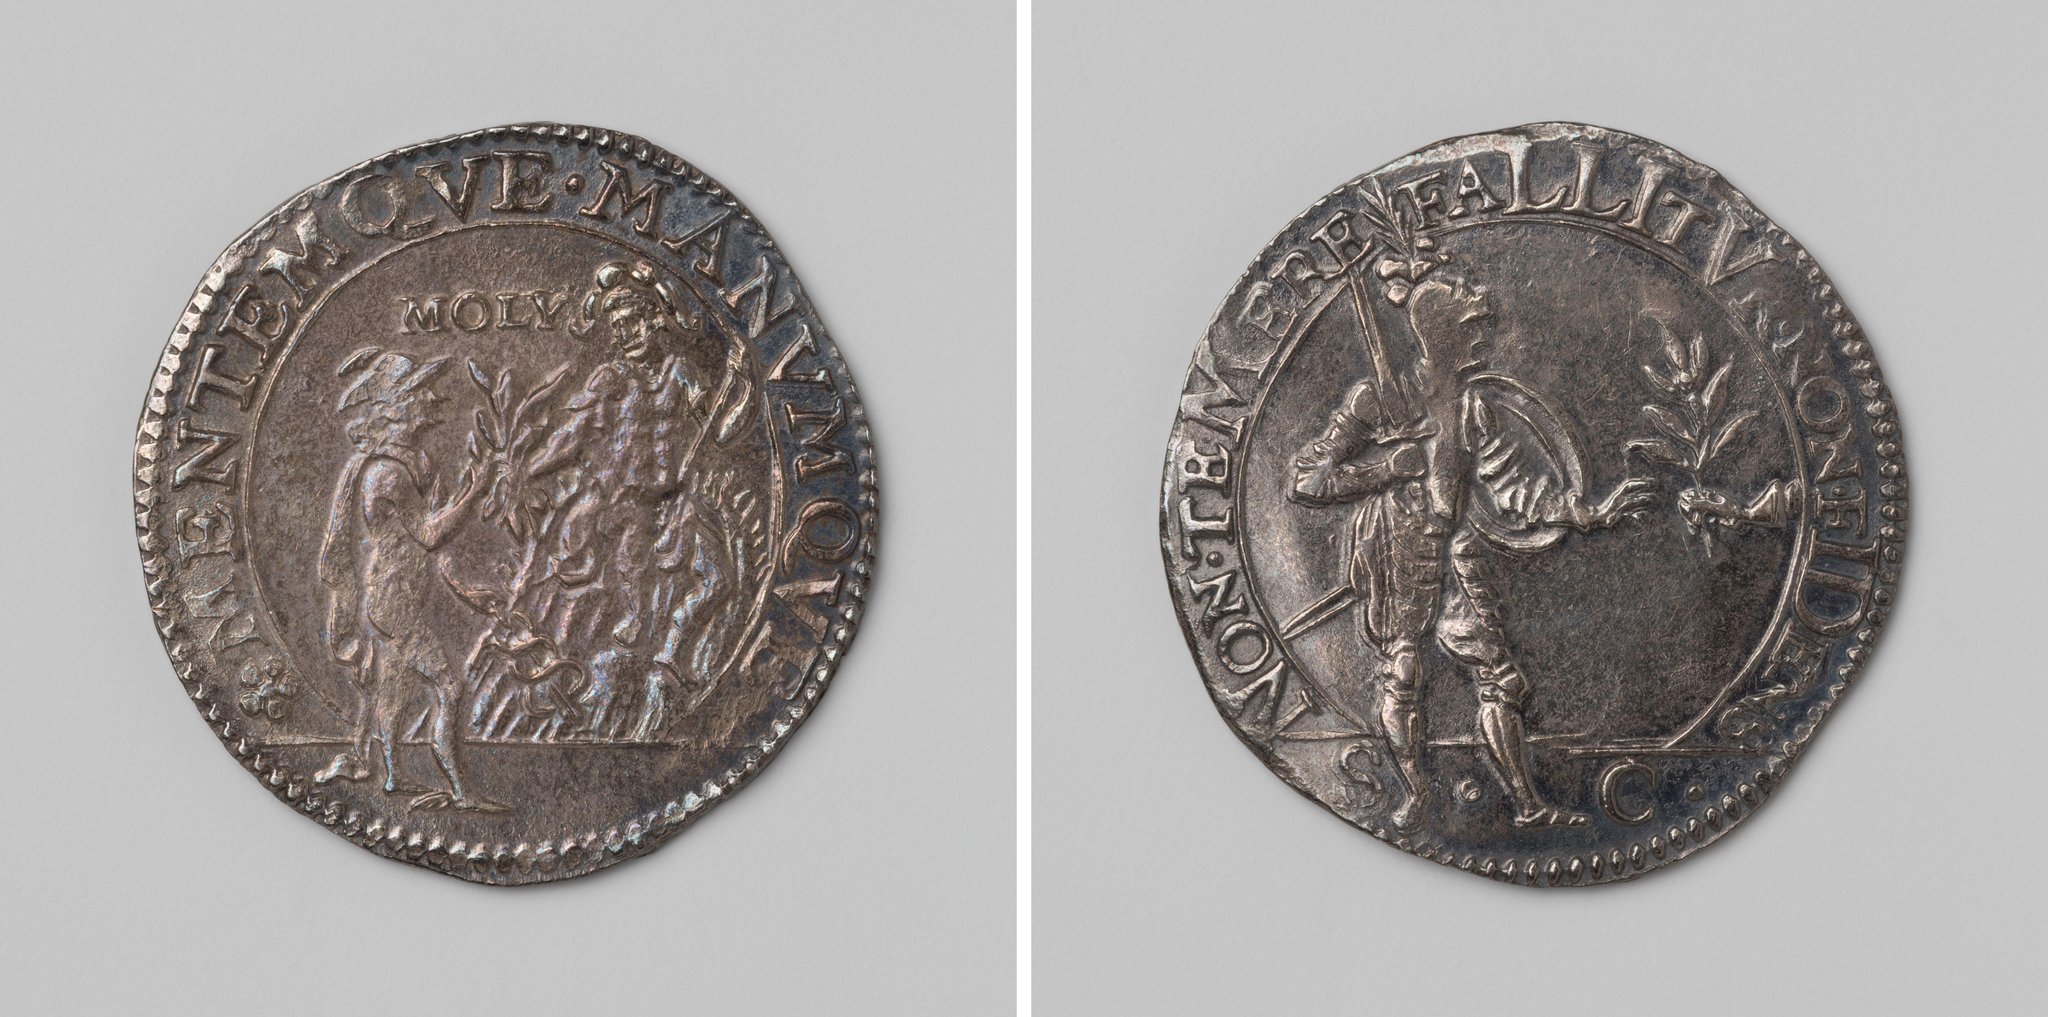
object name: jeton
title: Allegorische waarschuwing tegen de Spaanse vredesvoorstellen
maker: Anonymous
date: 1607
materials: silver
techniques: striking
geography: dordrecht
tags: the hague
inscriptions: circumscription: ‘MENTEMEQVE MANVMQVE’, circumscription: ‘NON TEMERE FALLITVR NON FIDENS / S C’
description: Zilveren penning. Voorzijde: Mercurius met gevleugelde helm en staf overhandigt Odysseus kruid, waarmee hij de verlokkingen van Cyrce kan weerstaan onder opschrift binnen omschrift. Keerzijde: hand biedt gewapende man een vredestak aan binnen omschrift; afsnede: monogram S.C.